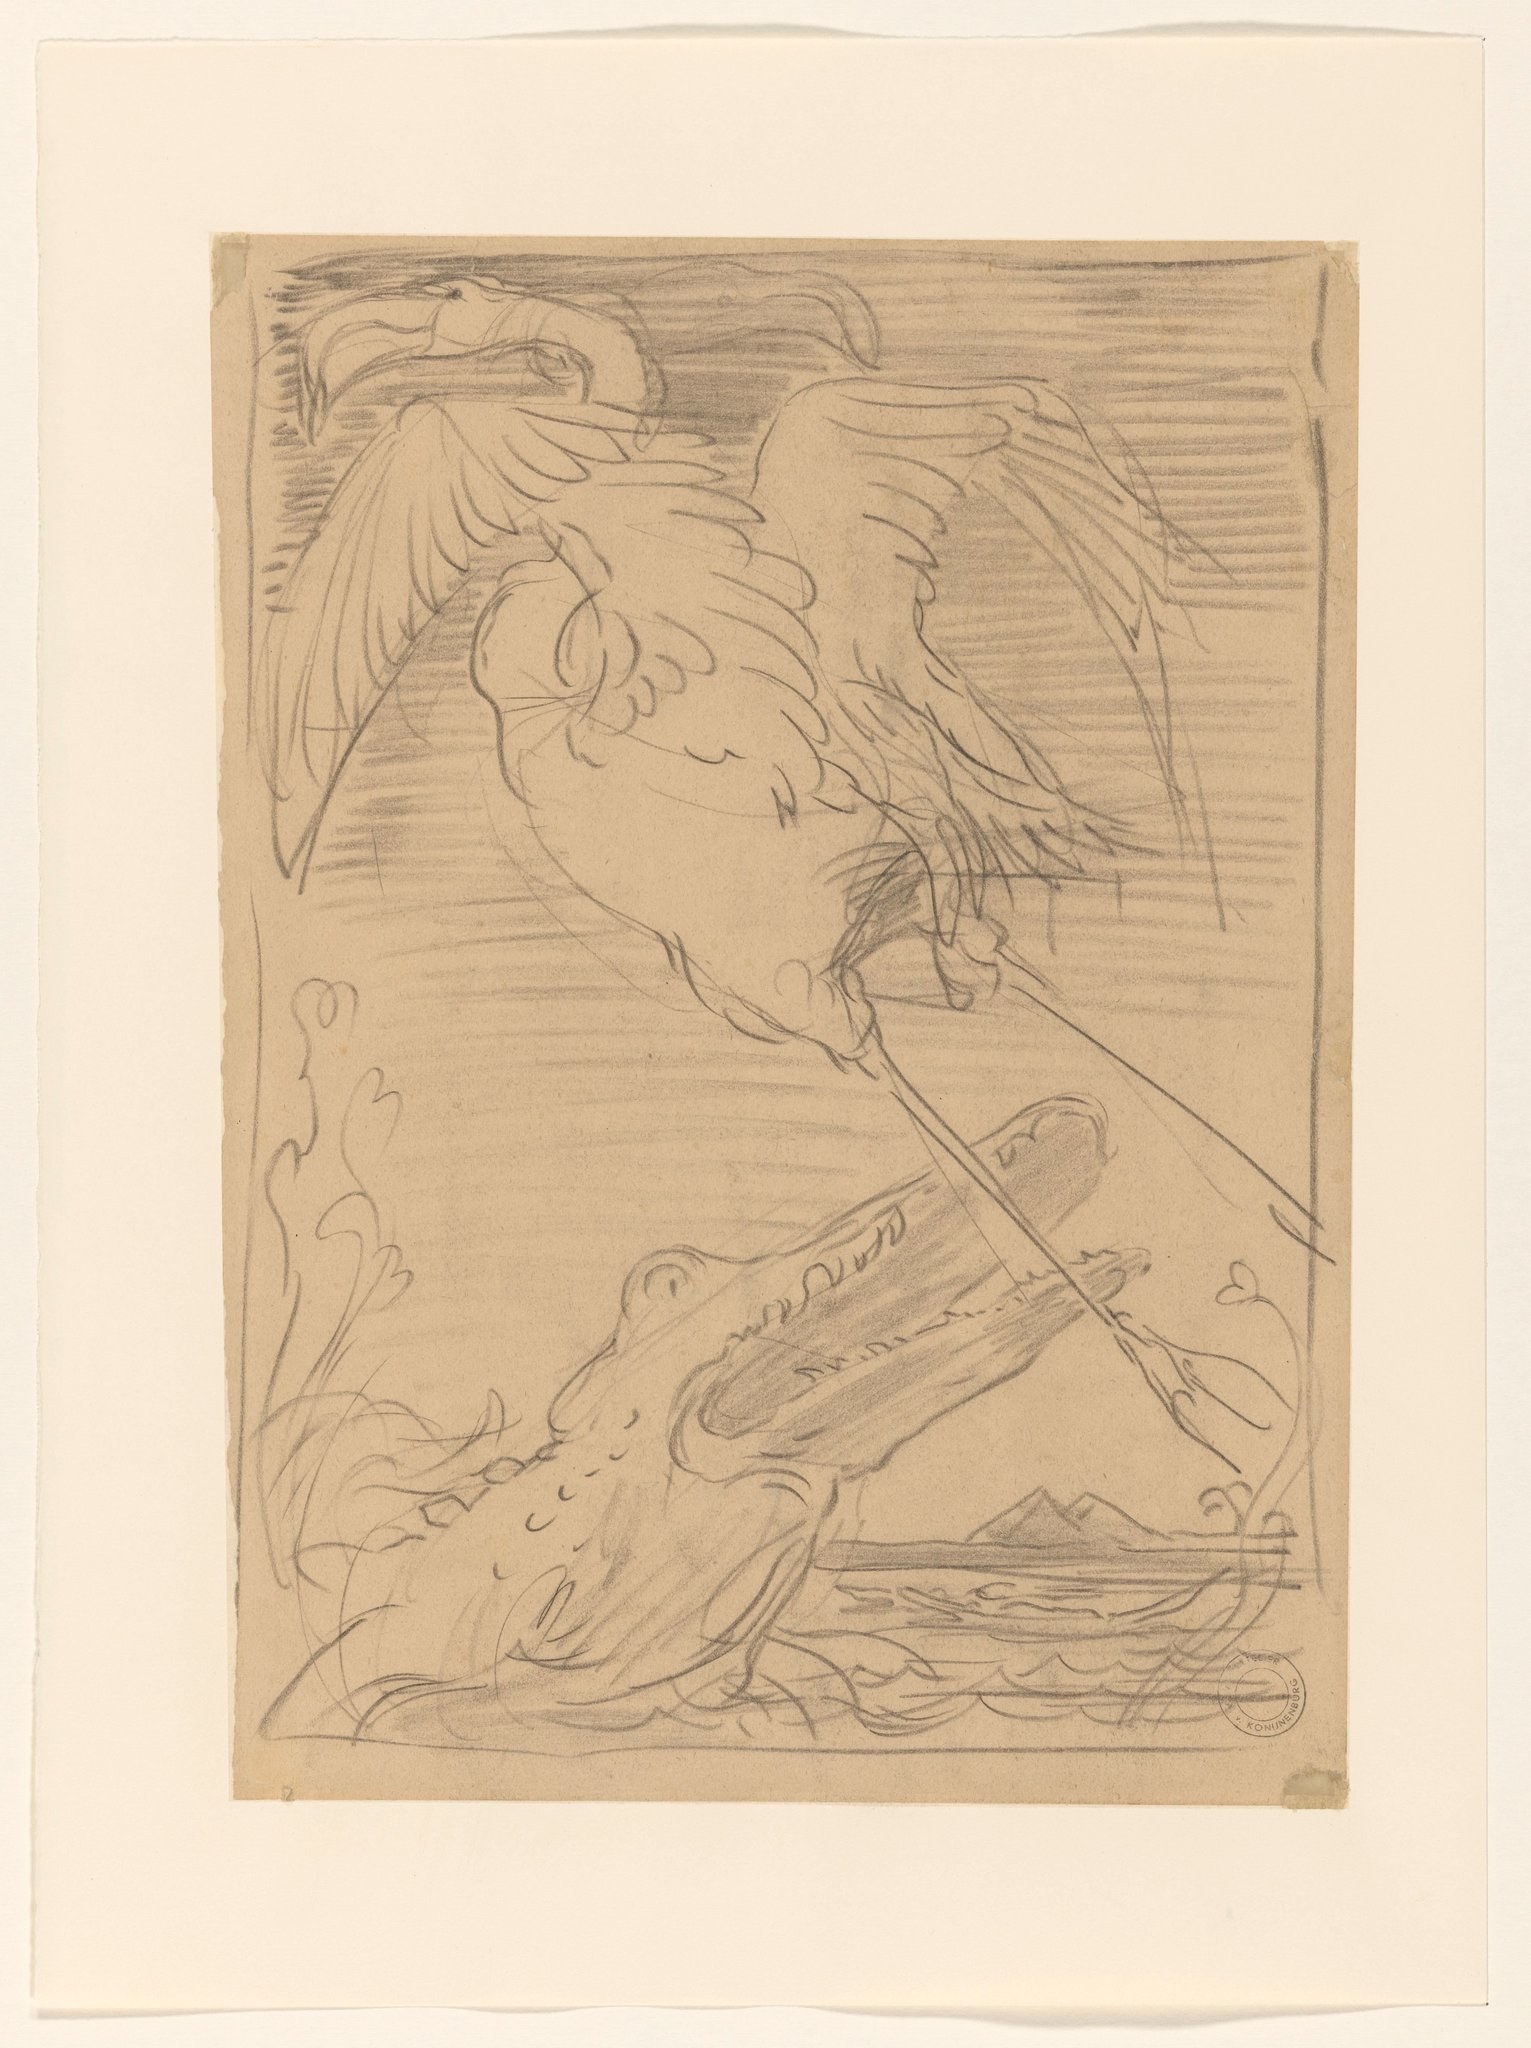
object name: drawing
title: Krokodil die naar een flamingo hapt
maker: willem van konijnenburg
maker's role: draughtsman, painter, print maker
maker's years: 1868-1943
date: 1878-1943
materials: chalk, paper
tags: shore-birds and wading-birds: flamingo, crocodiles: crocodile